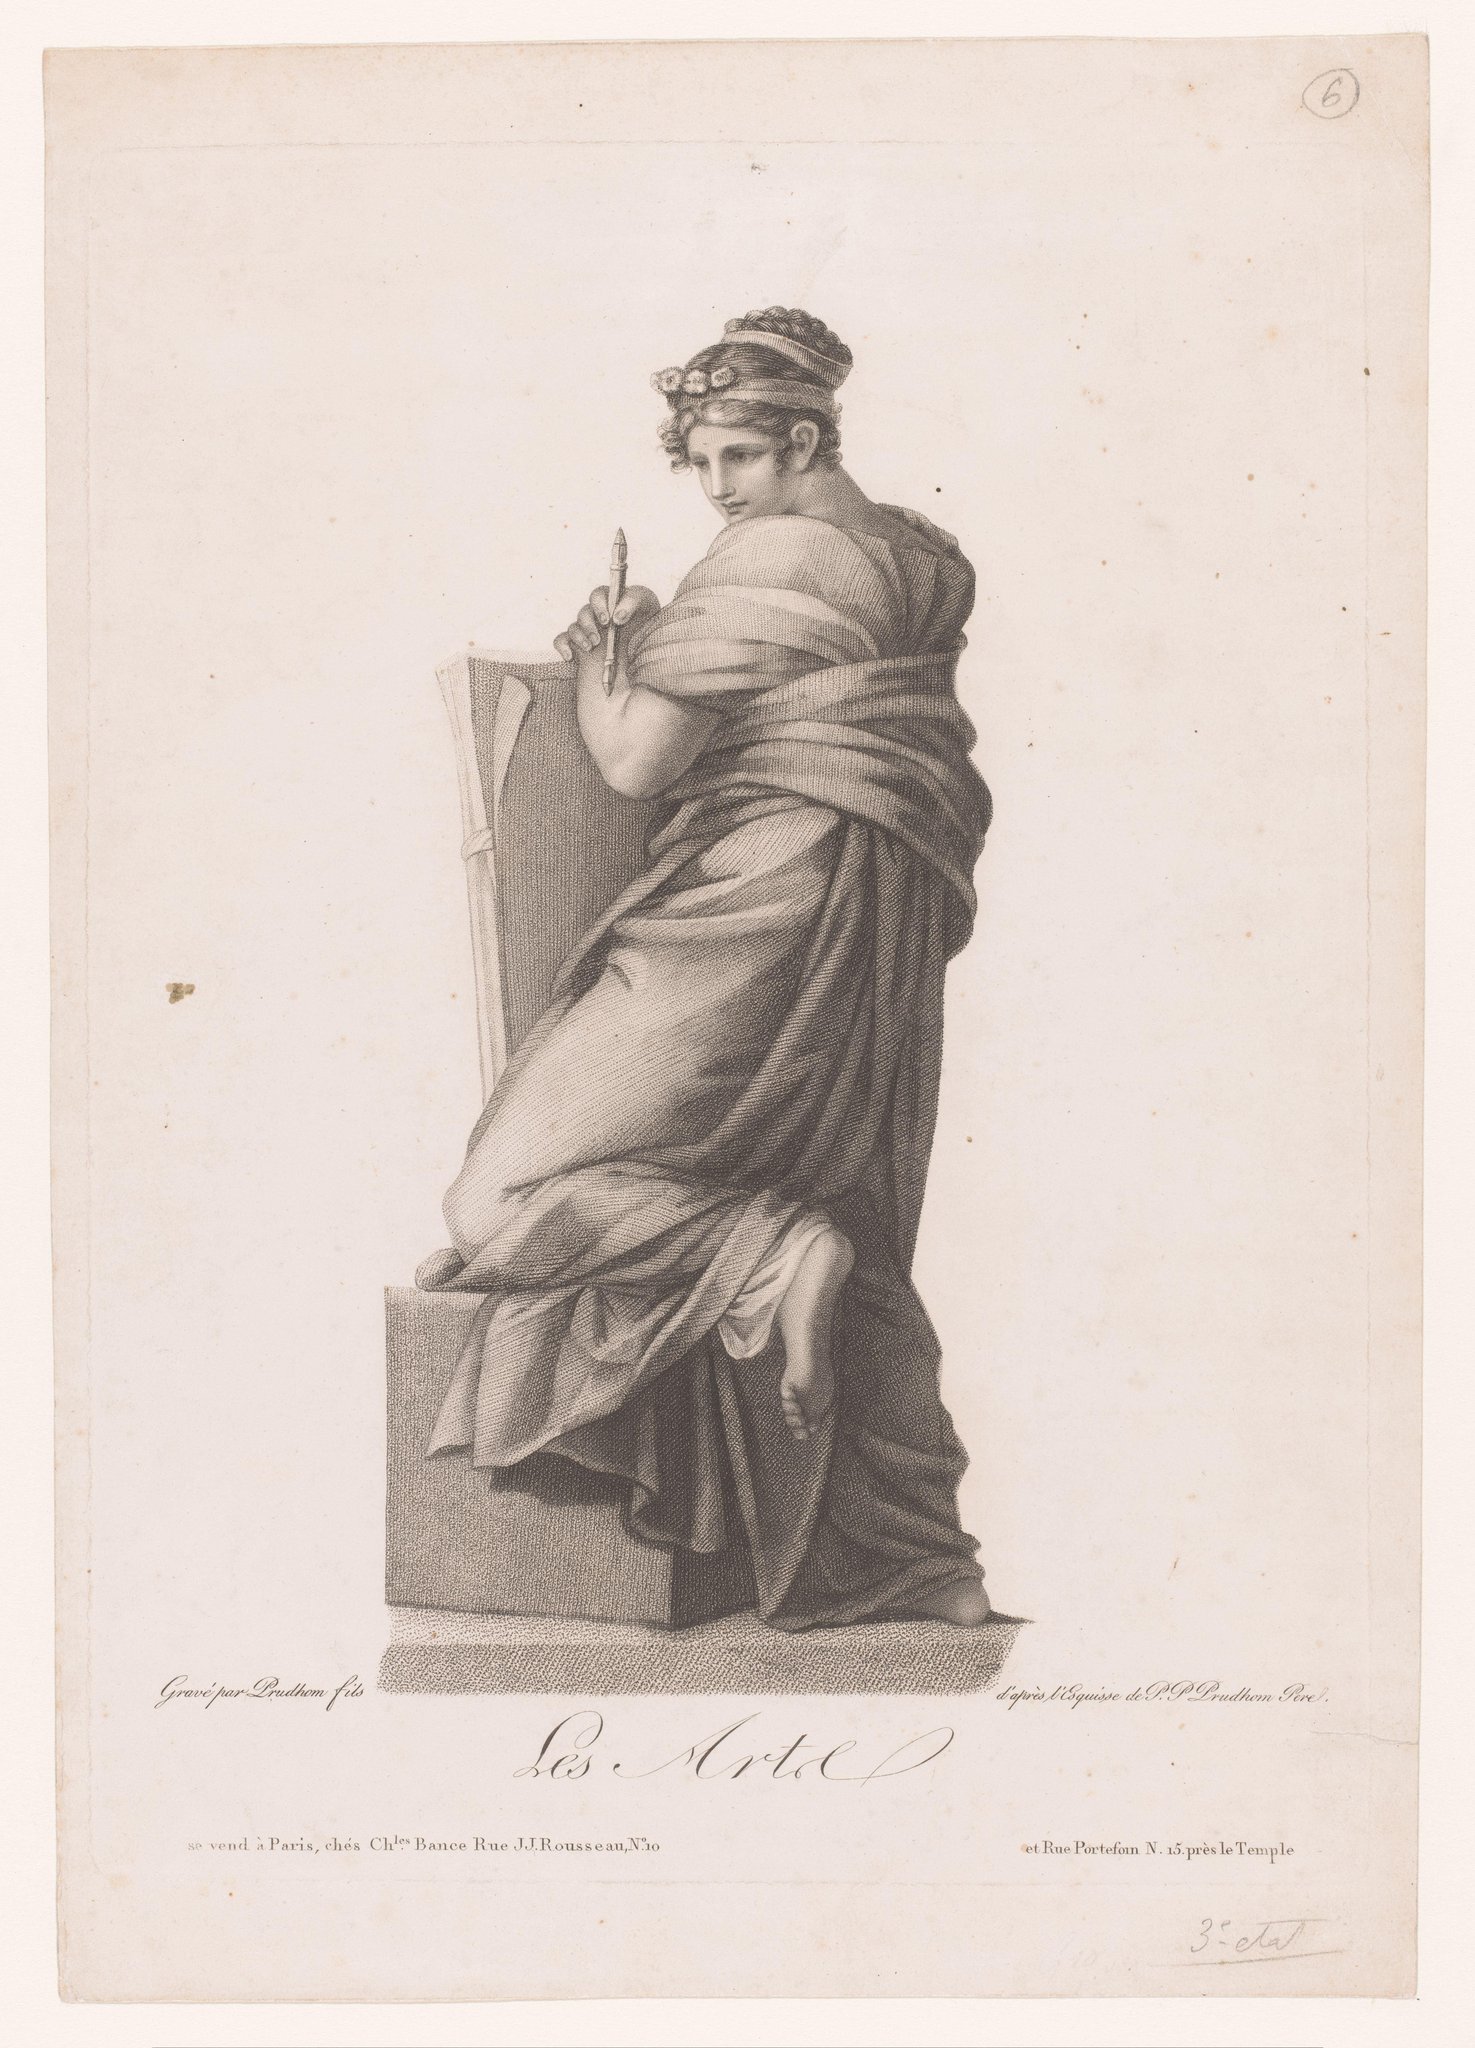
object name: print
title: Kunst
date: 1810-1823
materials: paper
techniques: engraving, etching, roulette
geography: paris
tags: symbolic representations, allegories and emblems ~ art; 'arte' (ripa)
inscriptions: collector's mark: Lugt 2228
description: Serie naar de figuren die als decoratie gebruikt zijn in het stadhuis, tijdens het huwelijk van Napoleon I Bonaparte en Marie Louise van Oostenrijk in 1810.